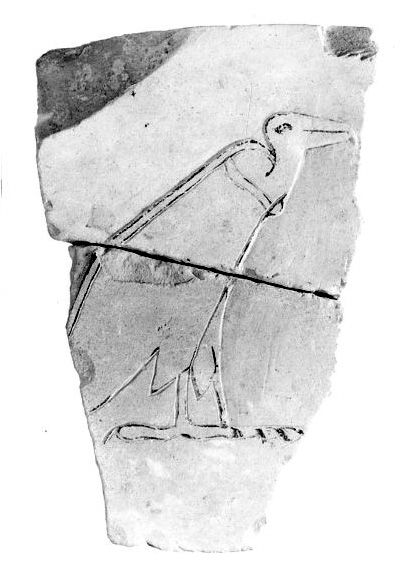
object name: relief fragment, tomb of meketre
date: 1981-1975 BCE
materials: limestone, paint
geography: egypt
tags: birds